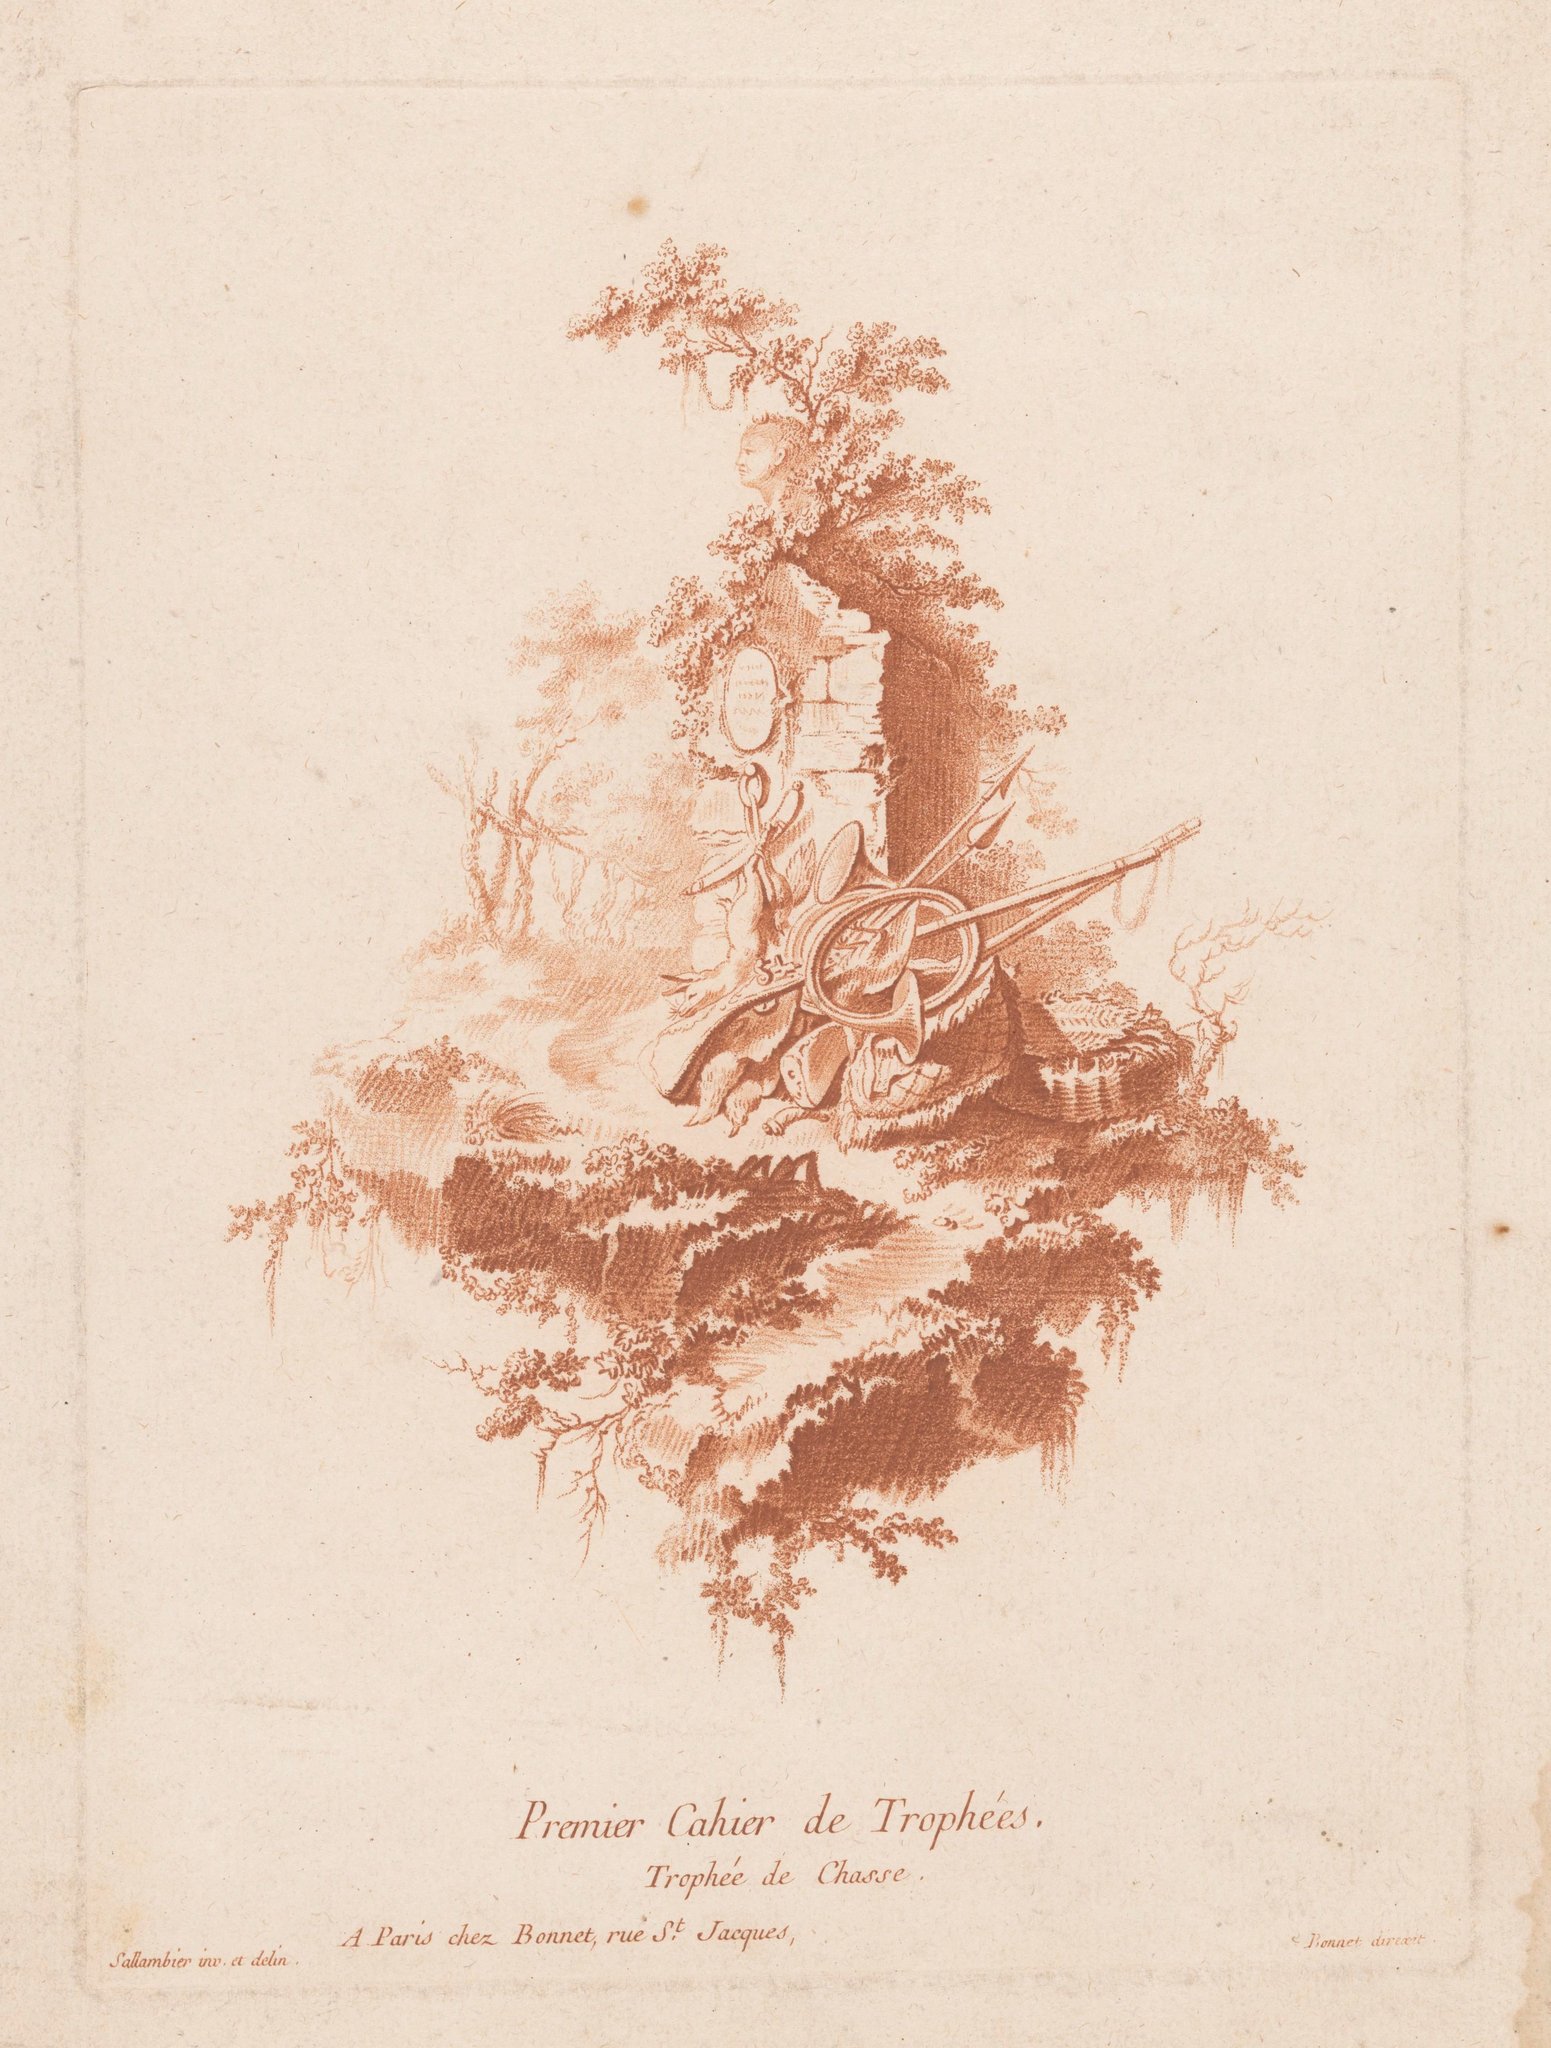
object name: print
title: Jachttrofee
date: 1763-1793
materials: paper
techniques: printmaking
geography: paris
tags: hunting trophies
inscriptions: collector's mark: Lugt 2760, collector's mark: Lugt 2228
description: In een landschap tegen een ruïne een jachttrofee met geschoten wild, geweren, speren en jachthoorns.